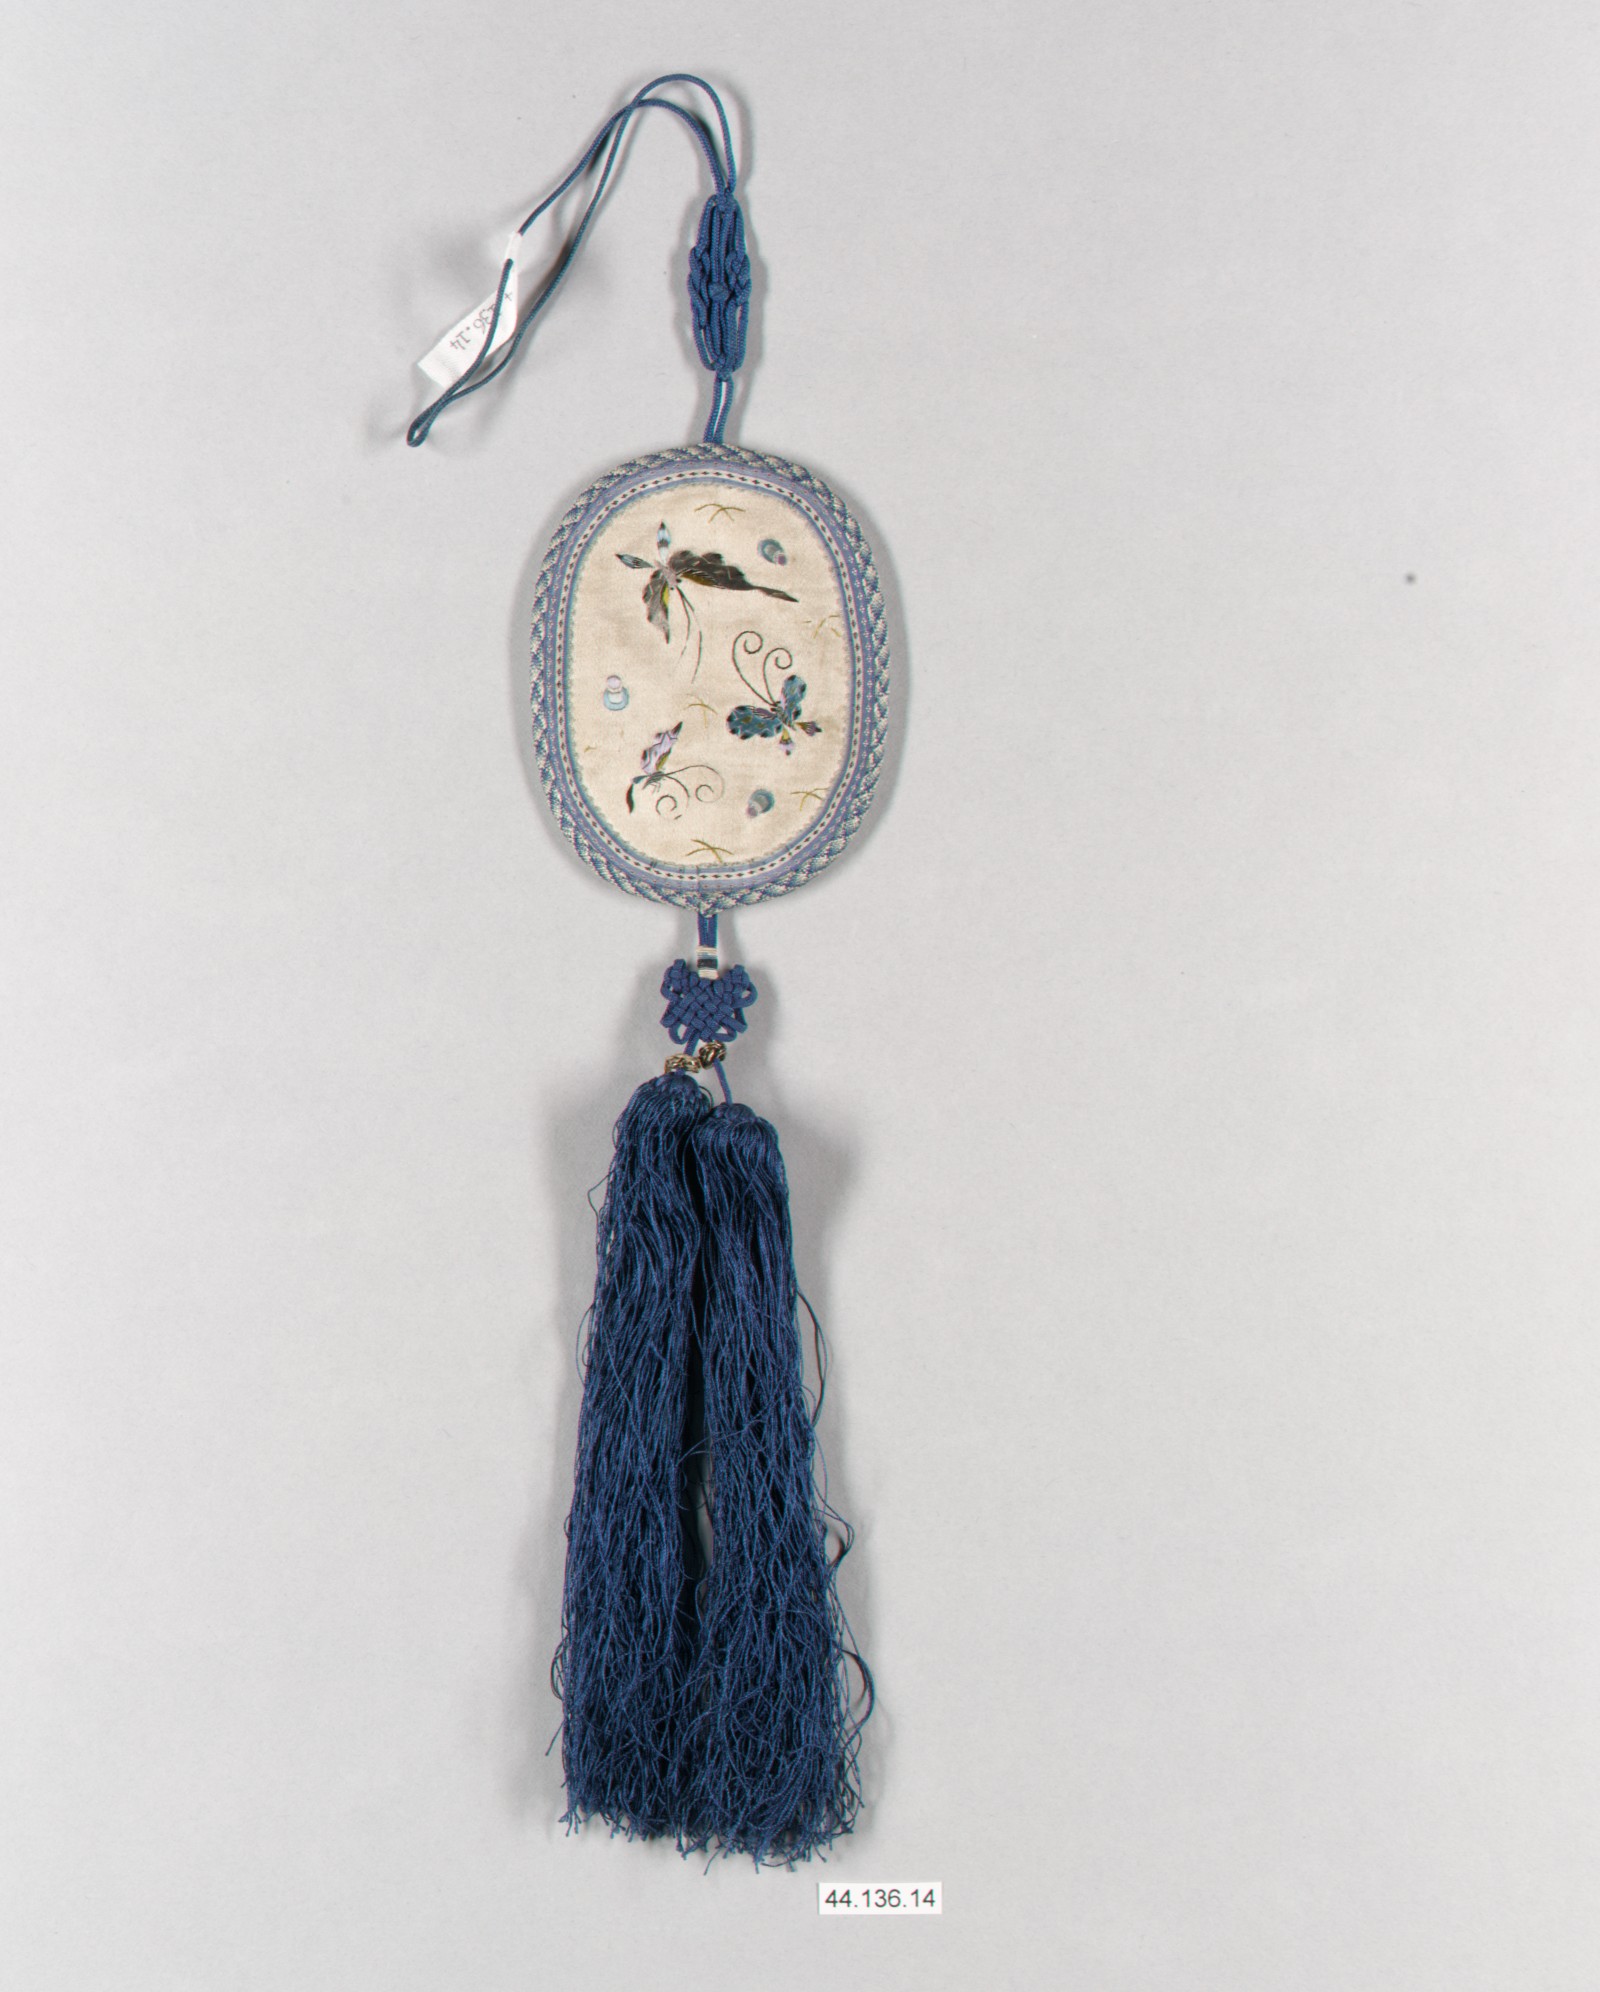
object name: mirror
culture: chinese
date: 1801-1900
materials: glass, silk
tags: butterflies